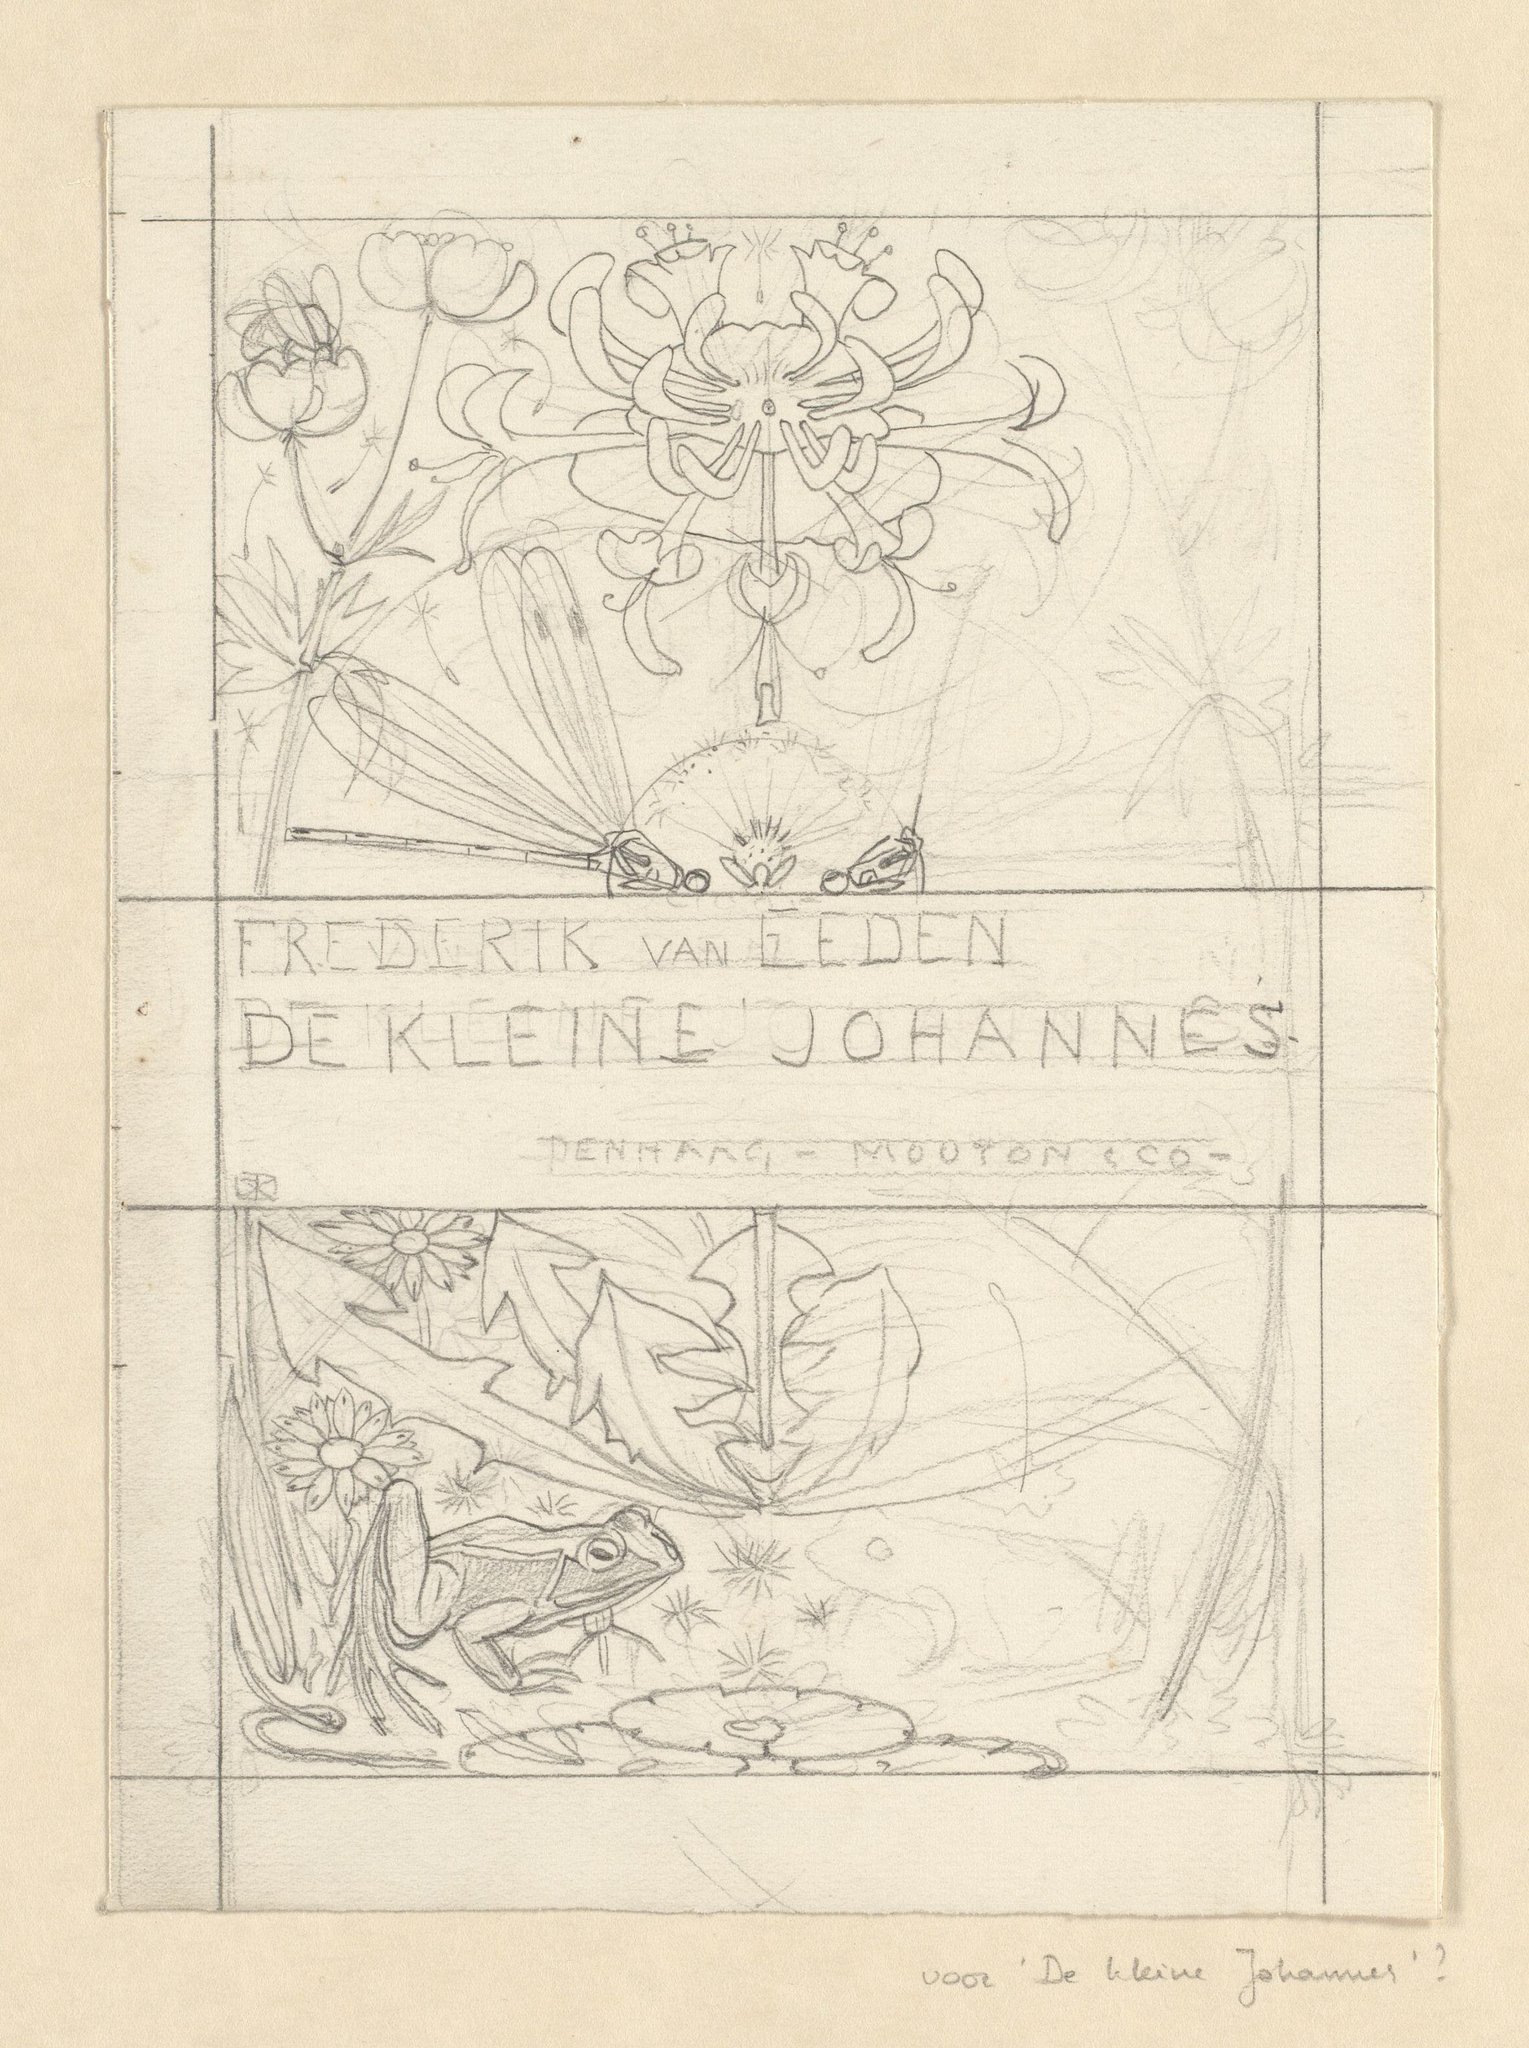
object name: design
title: Ontwerp voor een titelpagina voor: Frederik van Eeden, De kleine Johannes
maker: edzard koning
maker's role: draughtsman, print maker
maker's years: 1869-1954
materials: paper, pencil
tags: flowers, tailless amphibians: frog, insects: dragon-fly, (van eeden, de kleine johannes) specific works of literature (with author, title)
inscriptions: collector's mark: Lugt 2228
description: Ontwerp voor: Eeden, Frederik van. De kleine Johannes. Den Haag: Mouton & Co., 1898. Niet gebruikt in de definitieve uitgave.